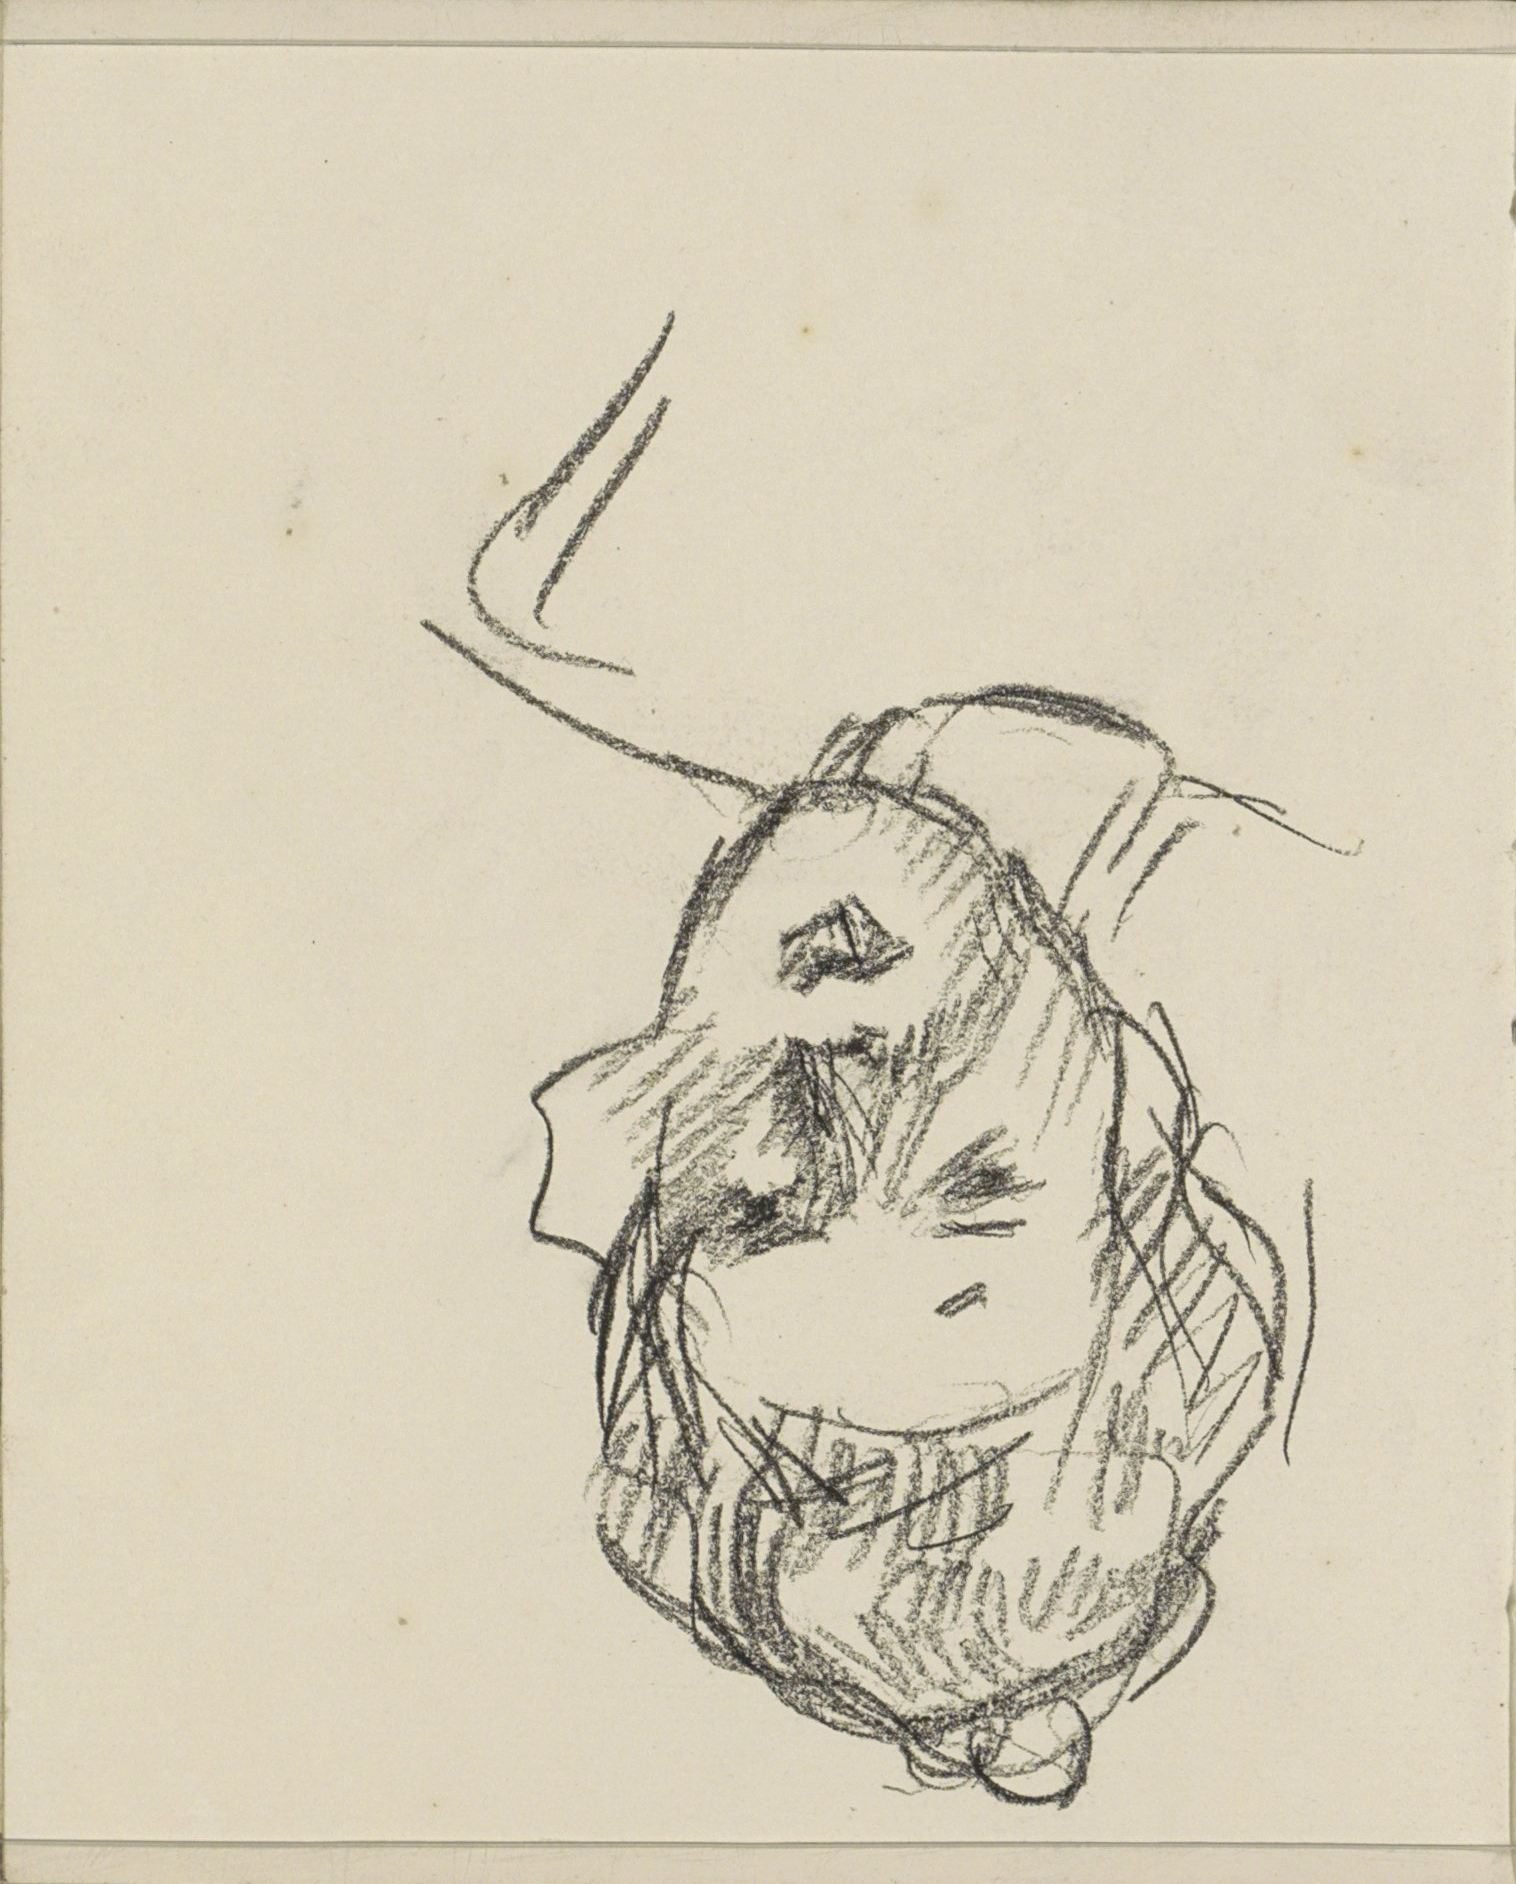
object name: sketchbook leaf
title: Vrouwenhoofd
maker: isaac israels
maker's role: draughtsman, painter, print maker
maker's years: 1865-1934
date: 1886-1903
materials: chalk, paper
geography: amsterdam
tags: head (human) - aa - female human figure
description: Pagina 50 uit schetsboek XXXII met 92 pagina's.